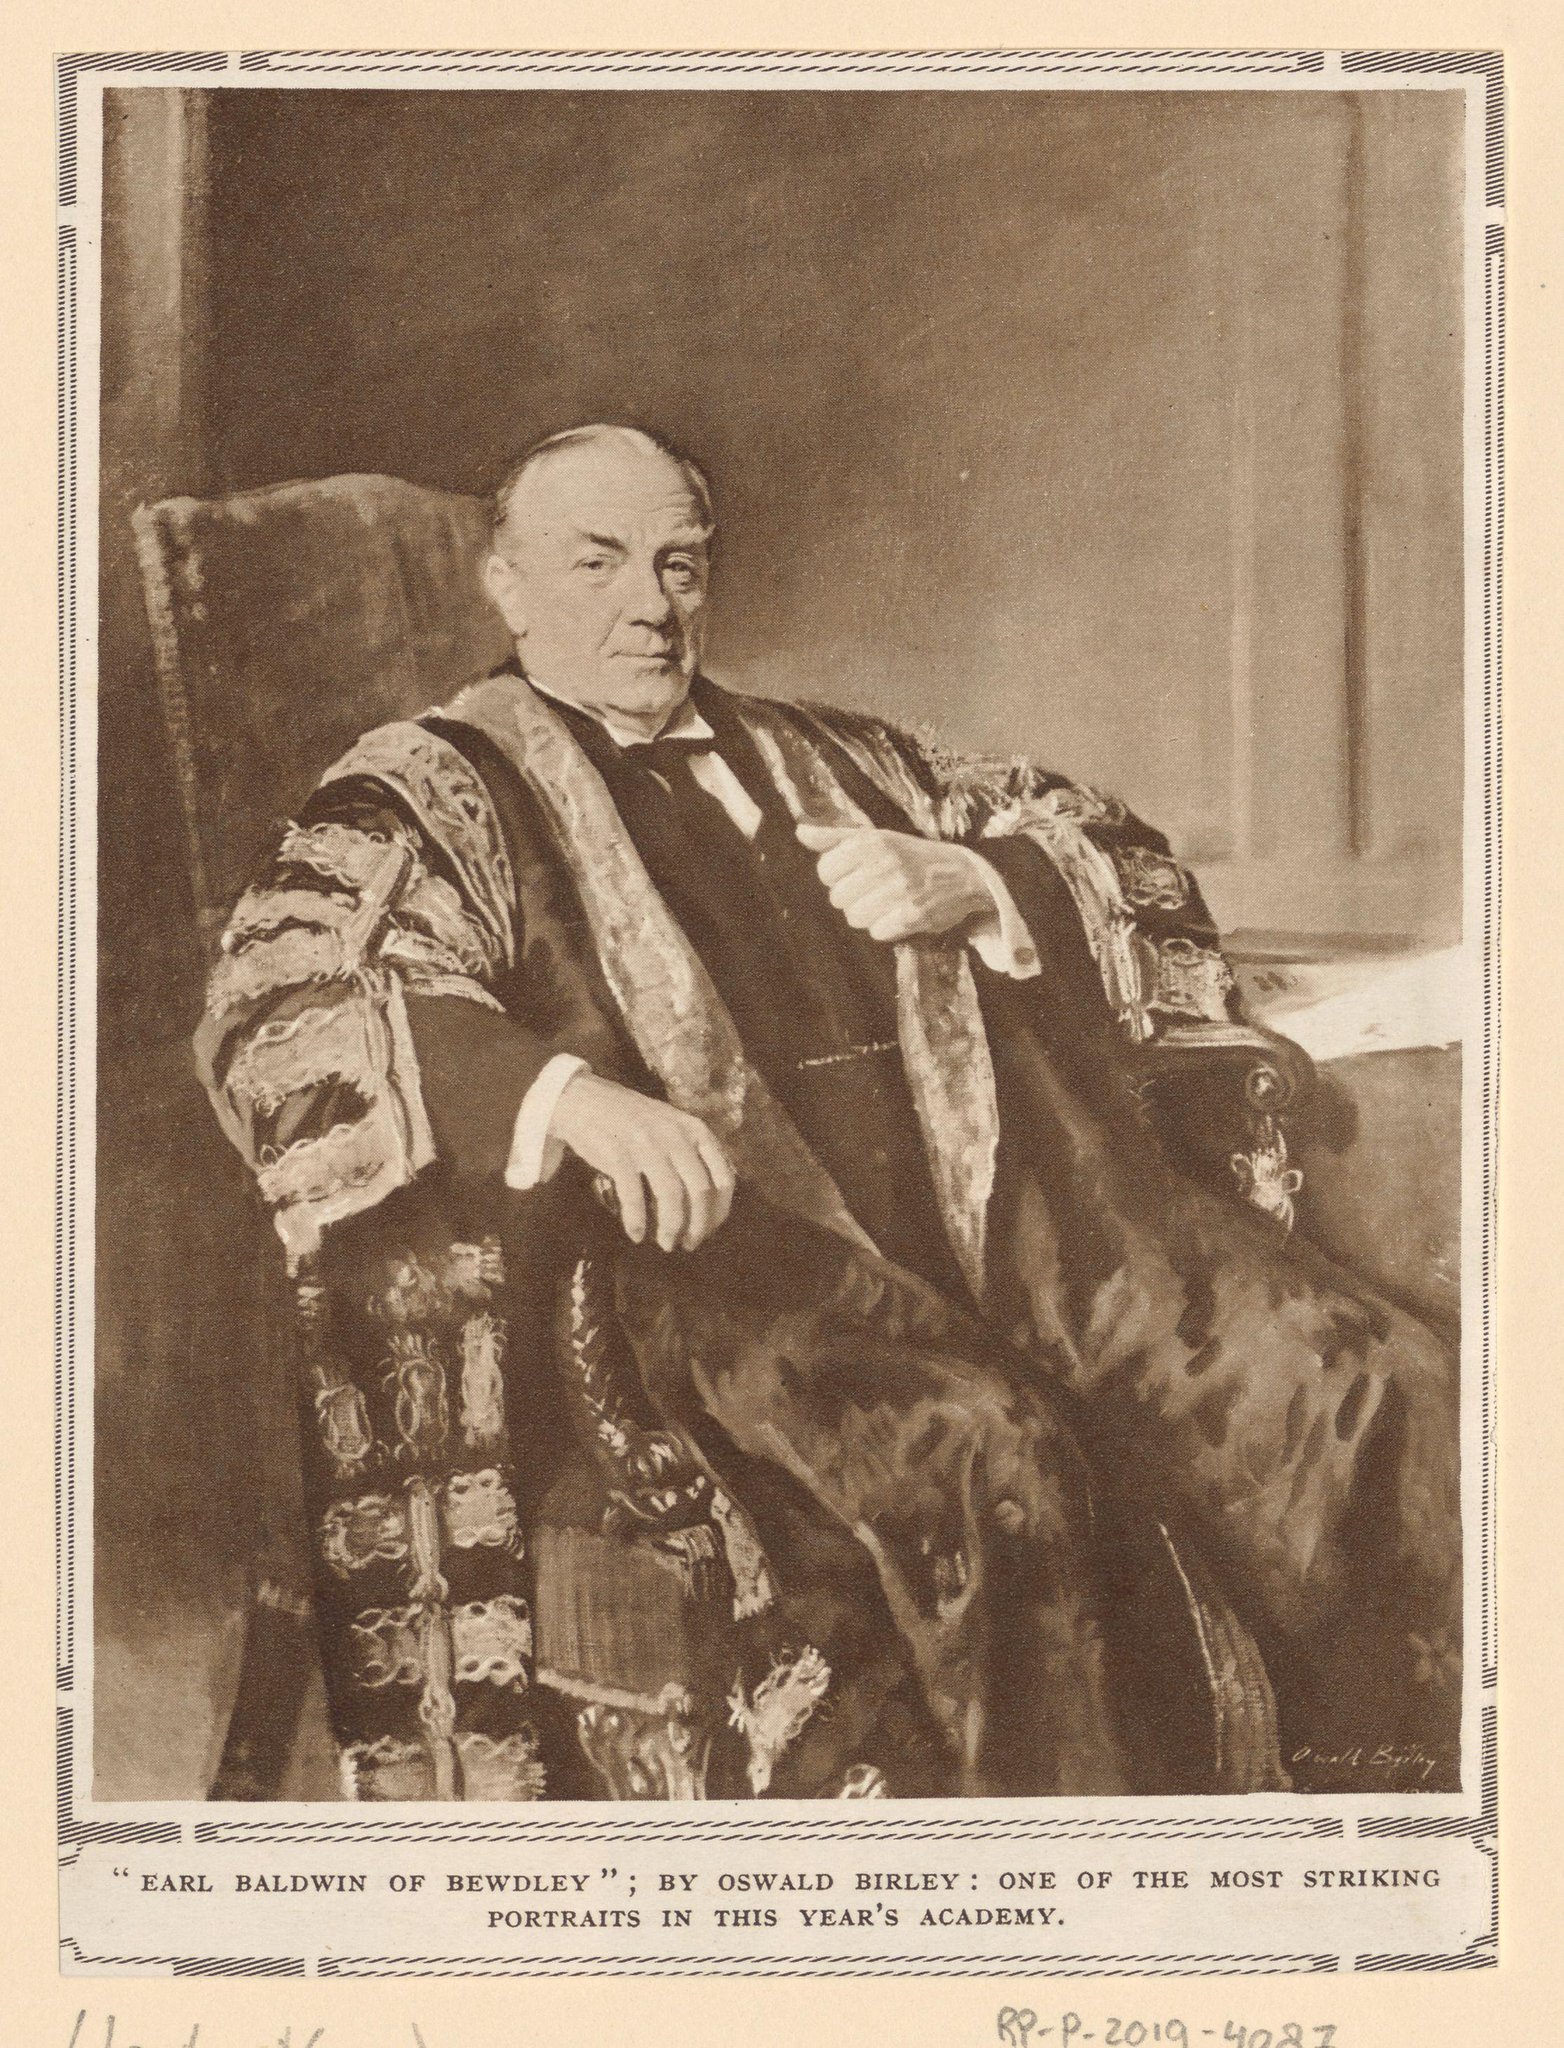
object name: photomechanical print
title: Portret van Stanley Baldwin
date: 1939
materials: paper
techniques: letterpress printing, rotogravure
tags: historical persons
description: Prent uit: The Illustrated London News, nr. 2714, 29 april 1939.